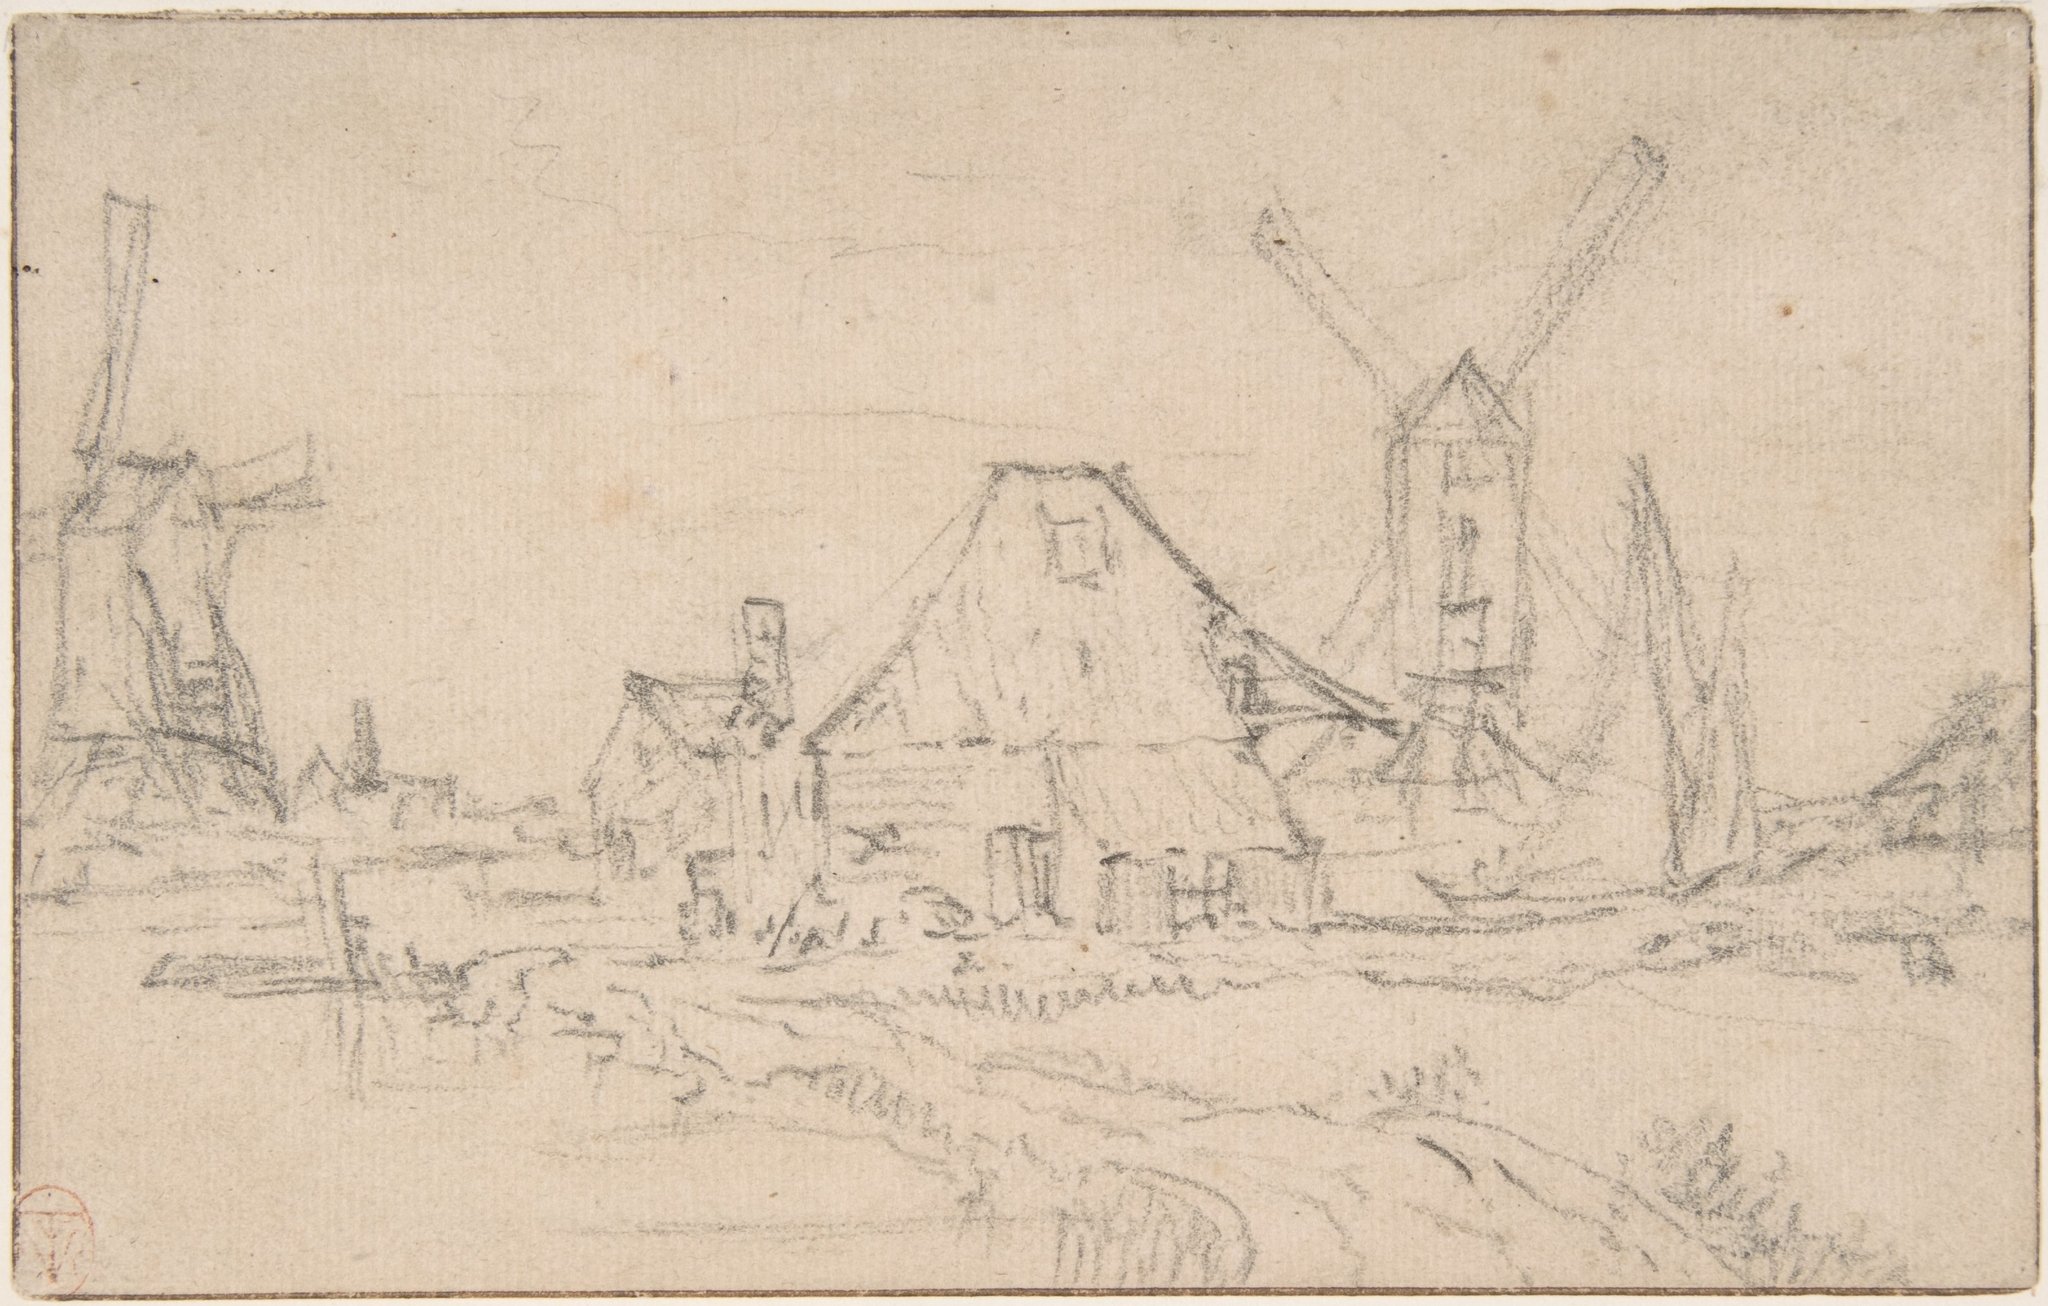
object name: drawing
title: Landscape With Two Mills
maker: rembrandt van rijn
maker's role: artist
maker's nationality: dutch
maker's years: 1606-1669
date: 1601-1700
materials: chalk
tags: windmills,landscapes